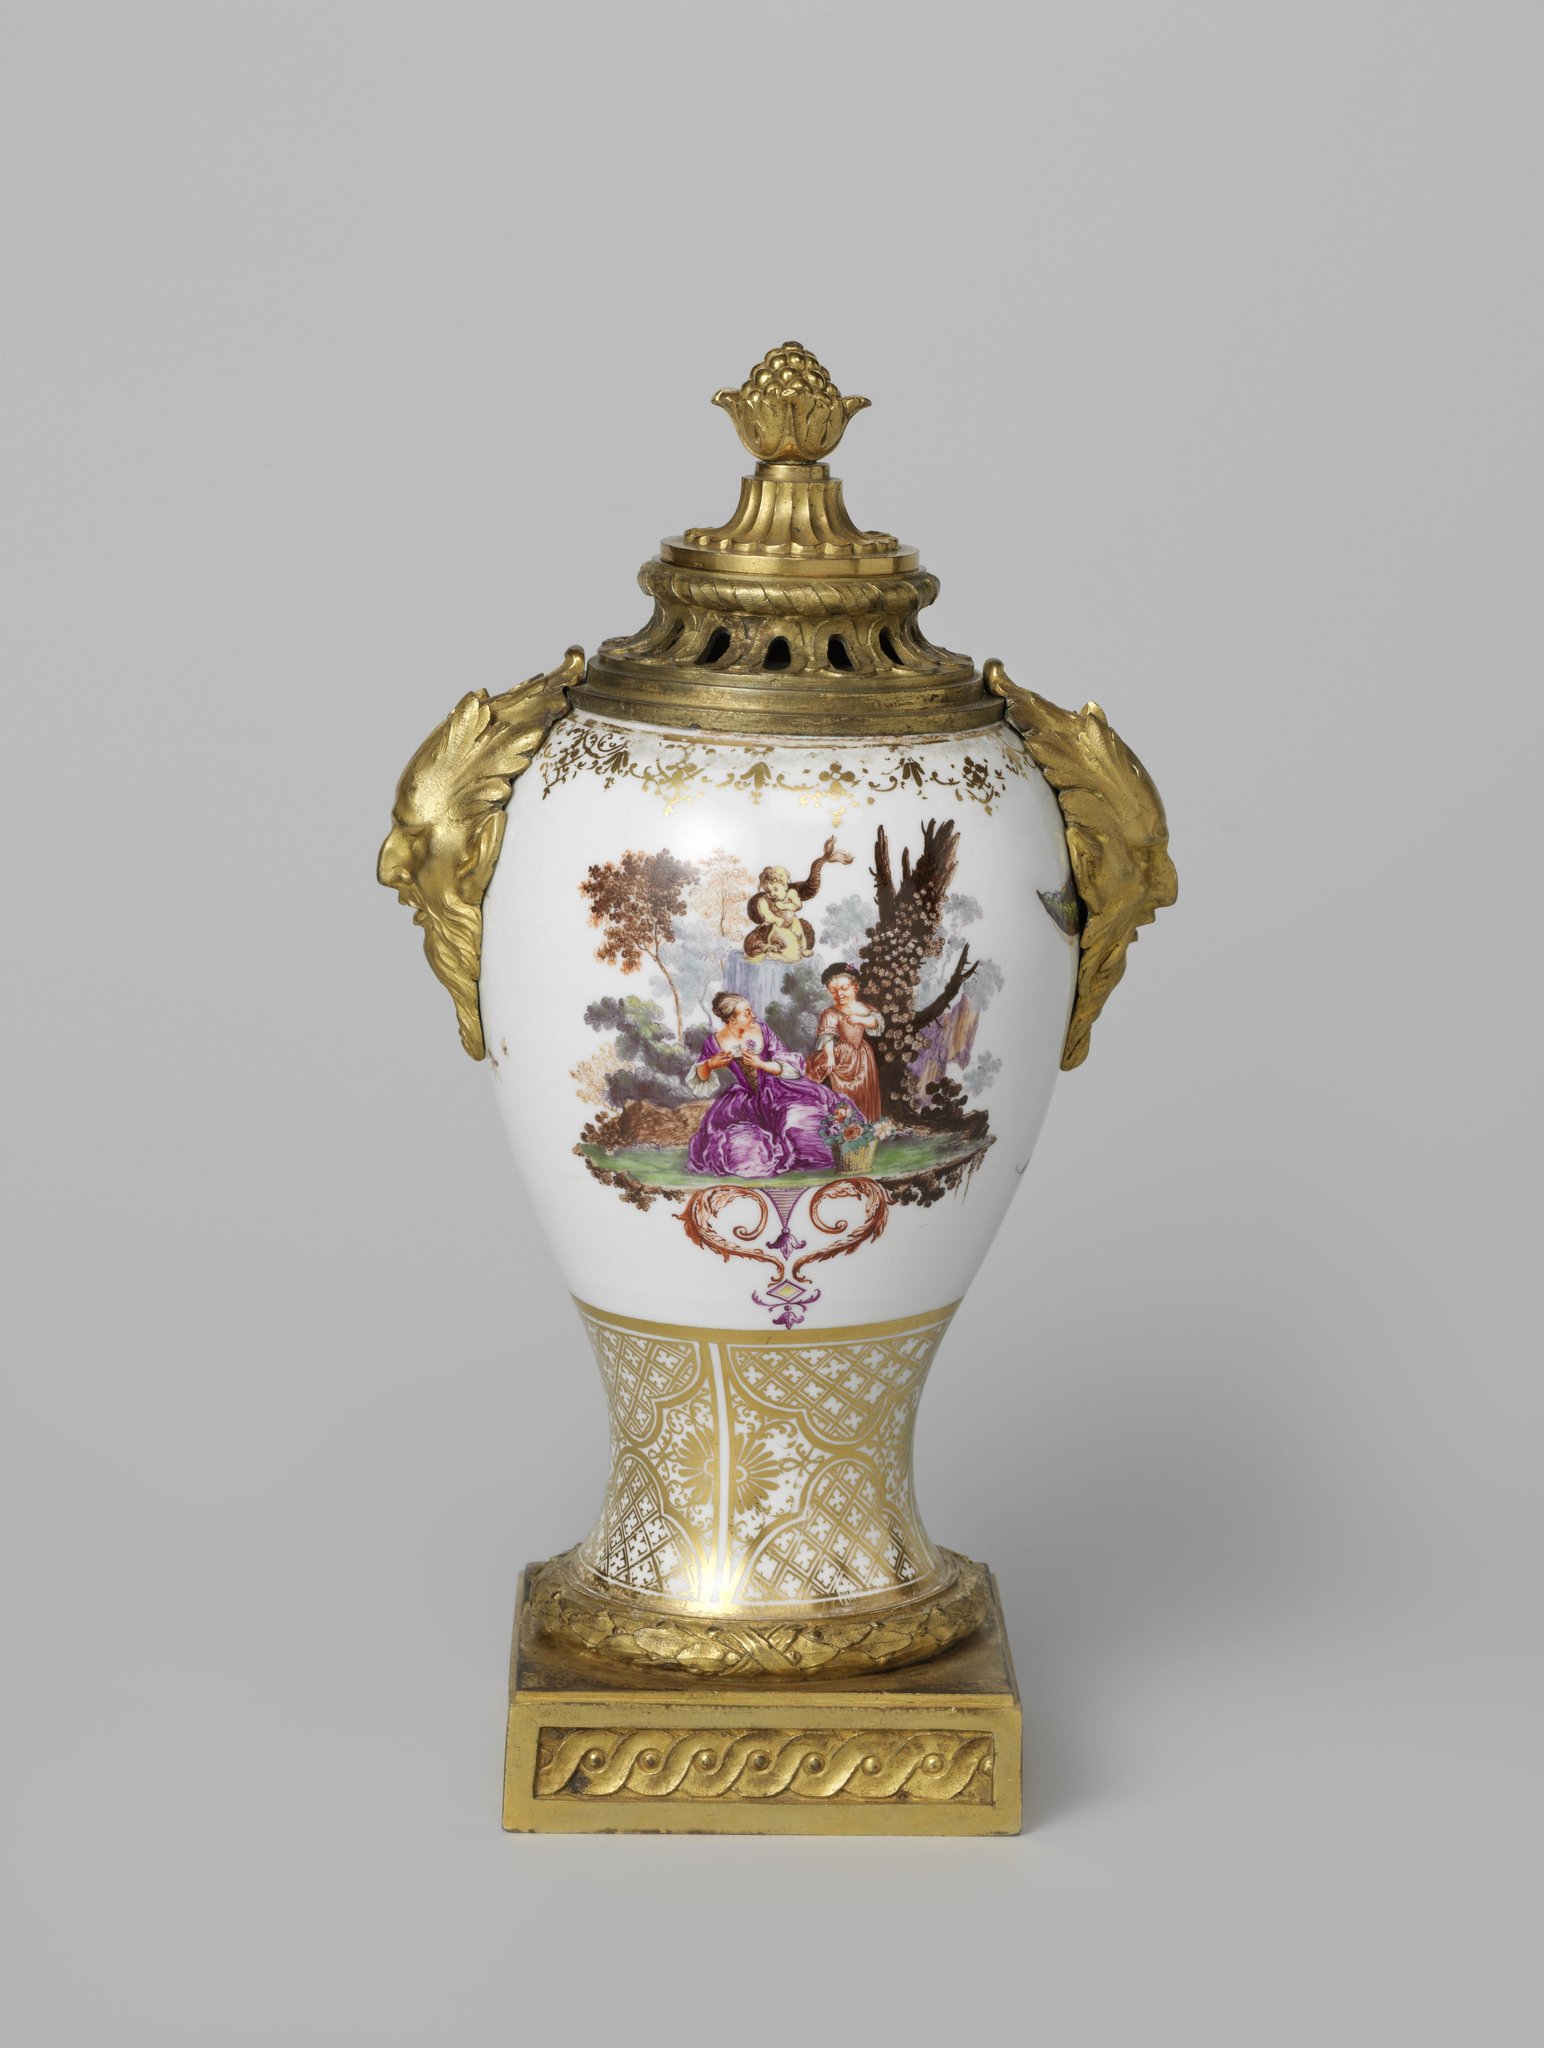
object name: vase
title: Three vases, part of a garniture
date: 1735-1740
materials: bronze, porcelain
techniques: gilding, painted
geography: meissen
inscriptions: factory mark: ‘AR’, inscription: ‘7//////’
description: Meissener Porzellan Manufaktur, after paintings by Jean Antoine Watteau (1684–1721), Meissen, c. 1735–1740, hard-paste porcelain, gilt bronze